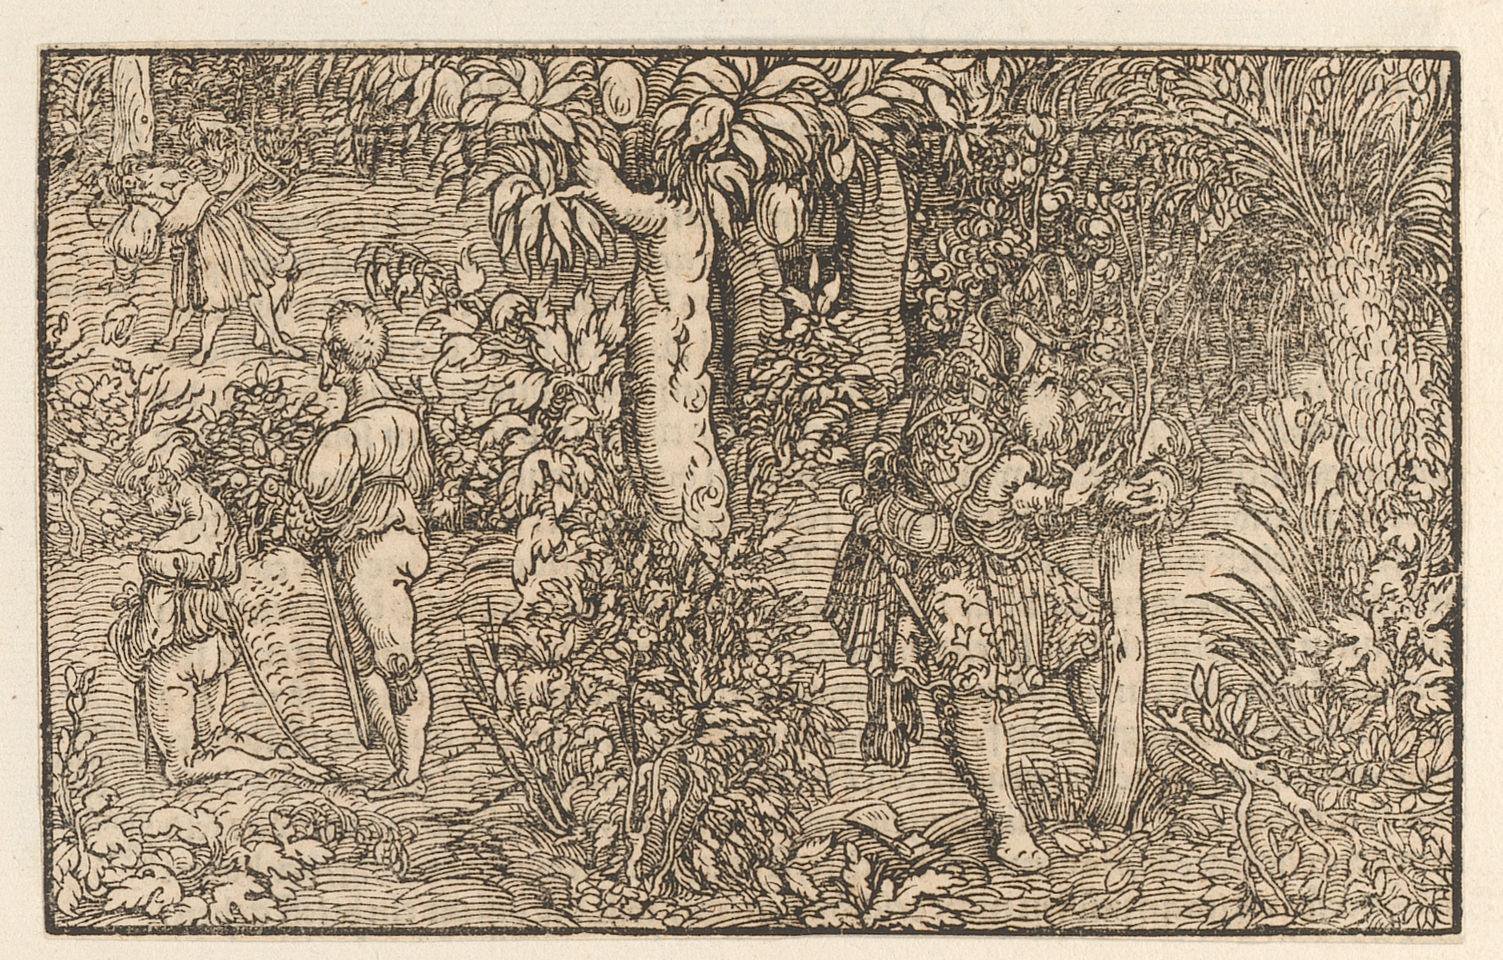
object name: album leaf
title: Heerser houdt een boomstronk vast en mensen worden omgebracht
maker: Anonymous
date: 1514-1532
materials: paper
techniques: letterpress printing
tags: trees, tools, aids, implements ~ crafts and industries: axe, fighting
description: Deze prent is gebruikt in: Petrarca, Francesco. Von der Artzney bayder Glück, des guten und widerwertigen: unnd weß sich ain yeder inn Gelück und Unglück halten sol (...). Augsburg: Heinrich Steiner, 1532. Deze uitgave is ook bekend onder de titel 'Trostspiegel in Glück und Unglück'.